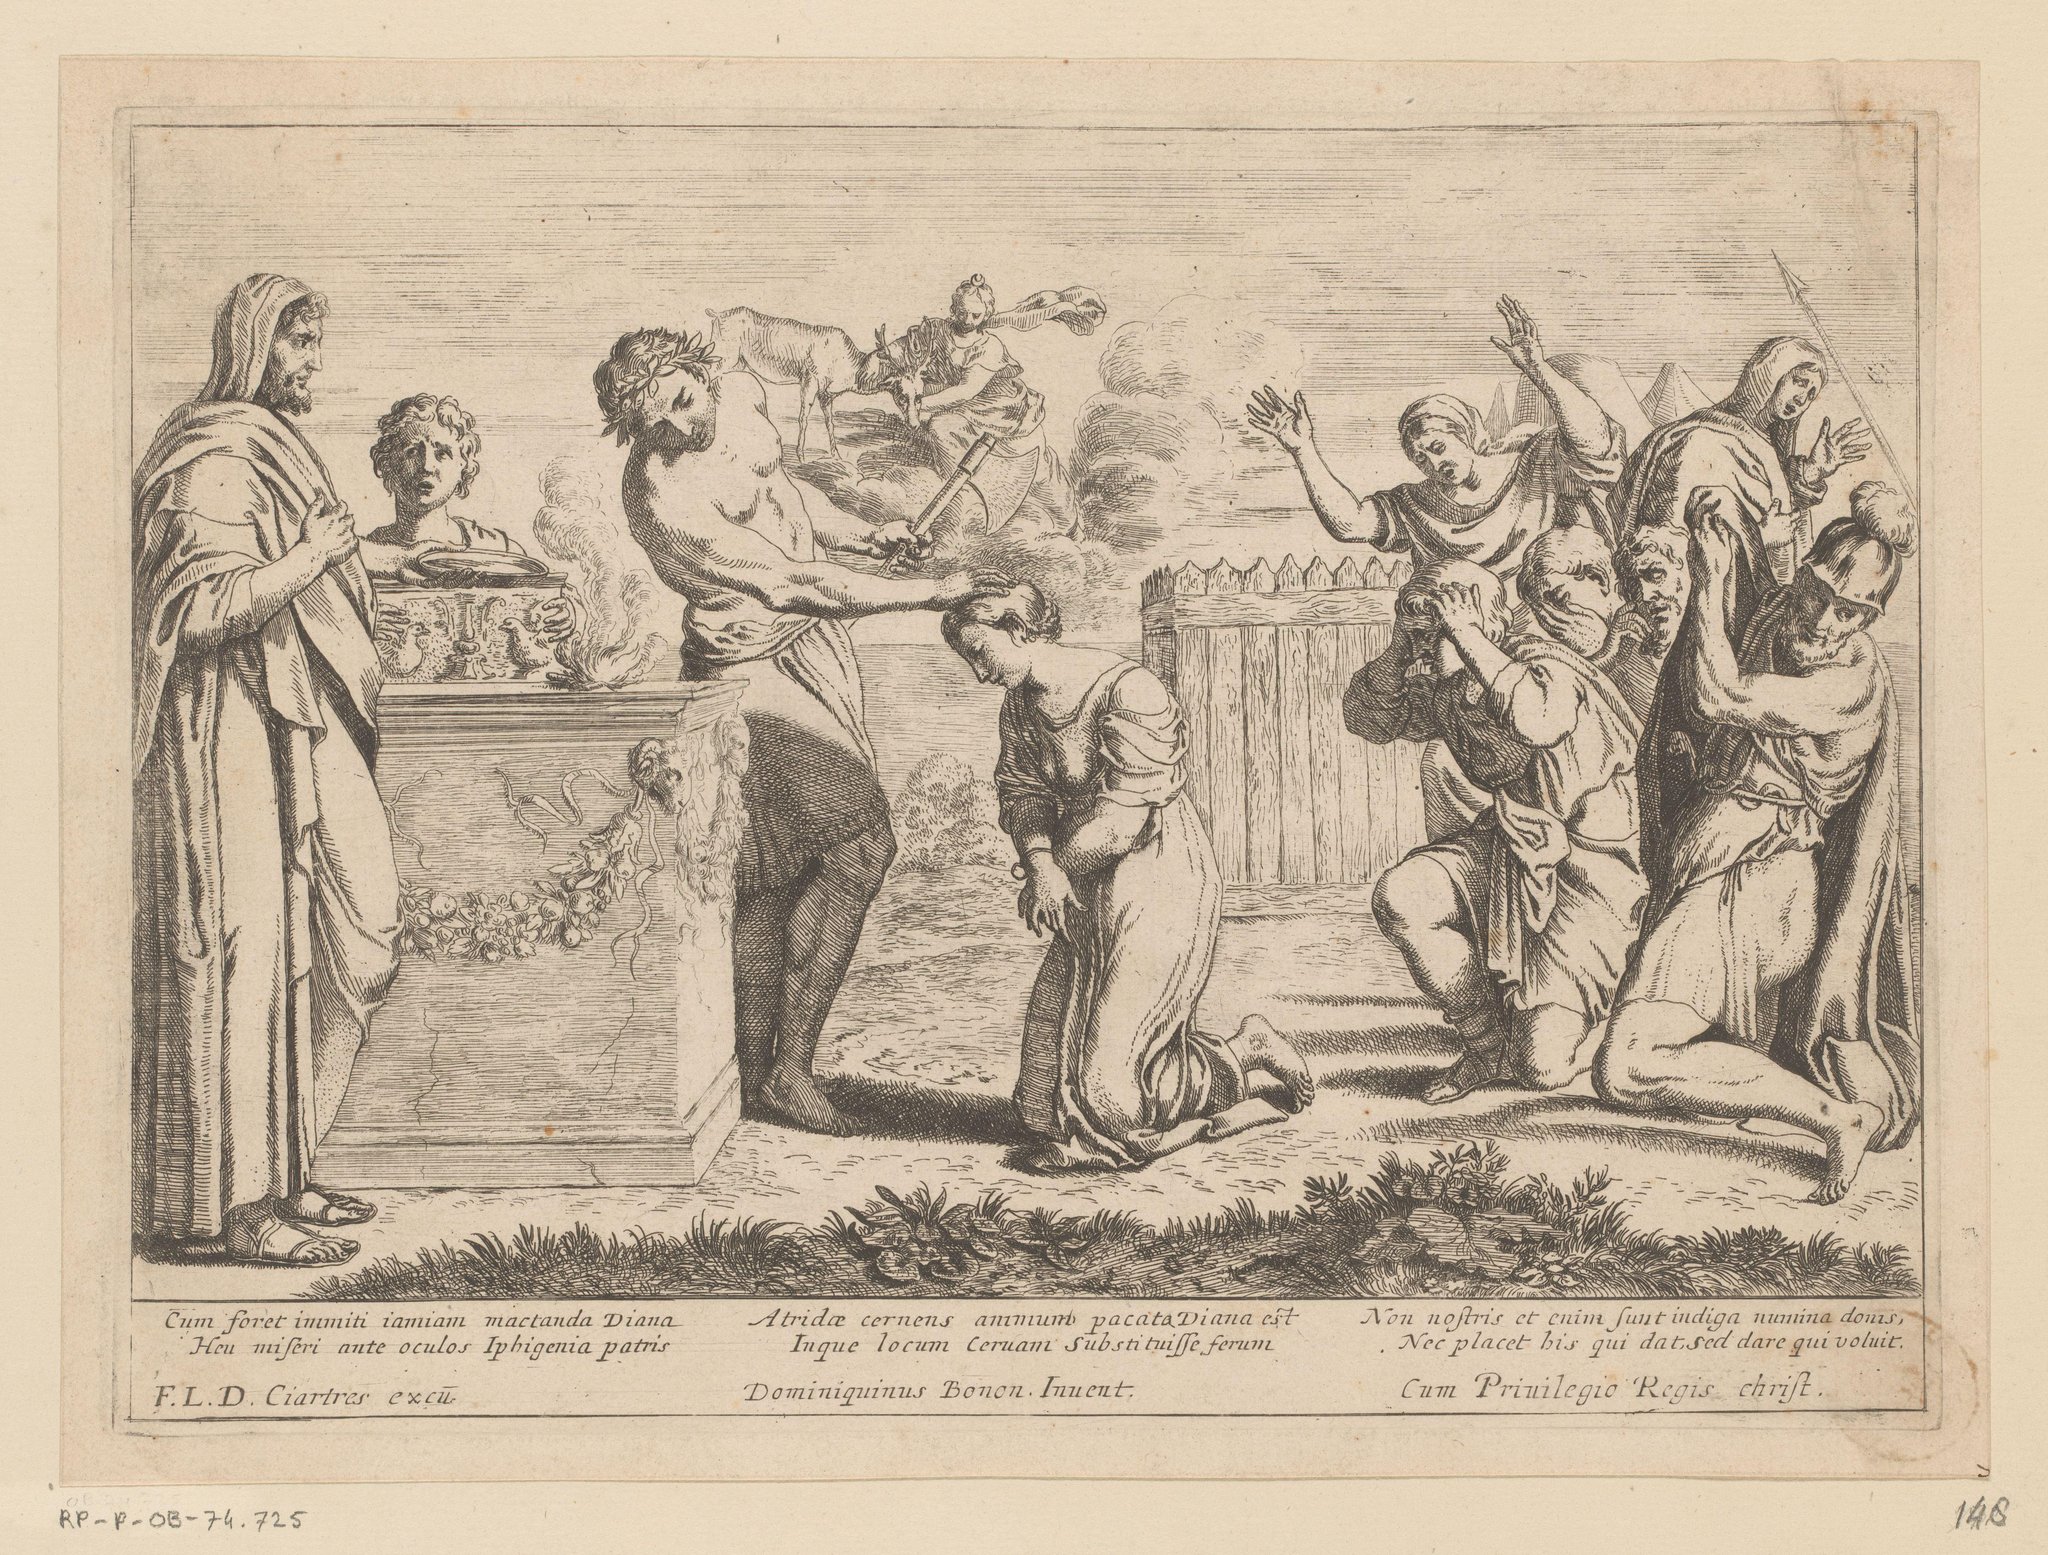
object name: print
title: Offer van Iphigeneia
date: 1599-1647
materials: paper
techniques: etching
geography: france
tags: the sacrifice of iphigenia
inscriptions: collector's mark: Lugt 240